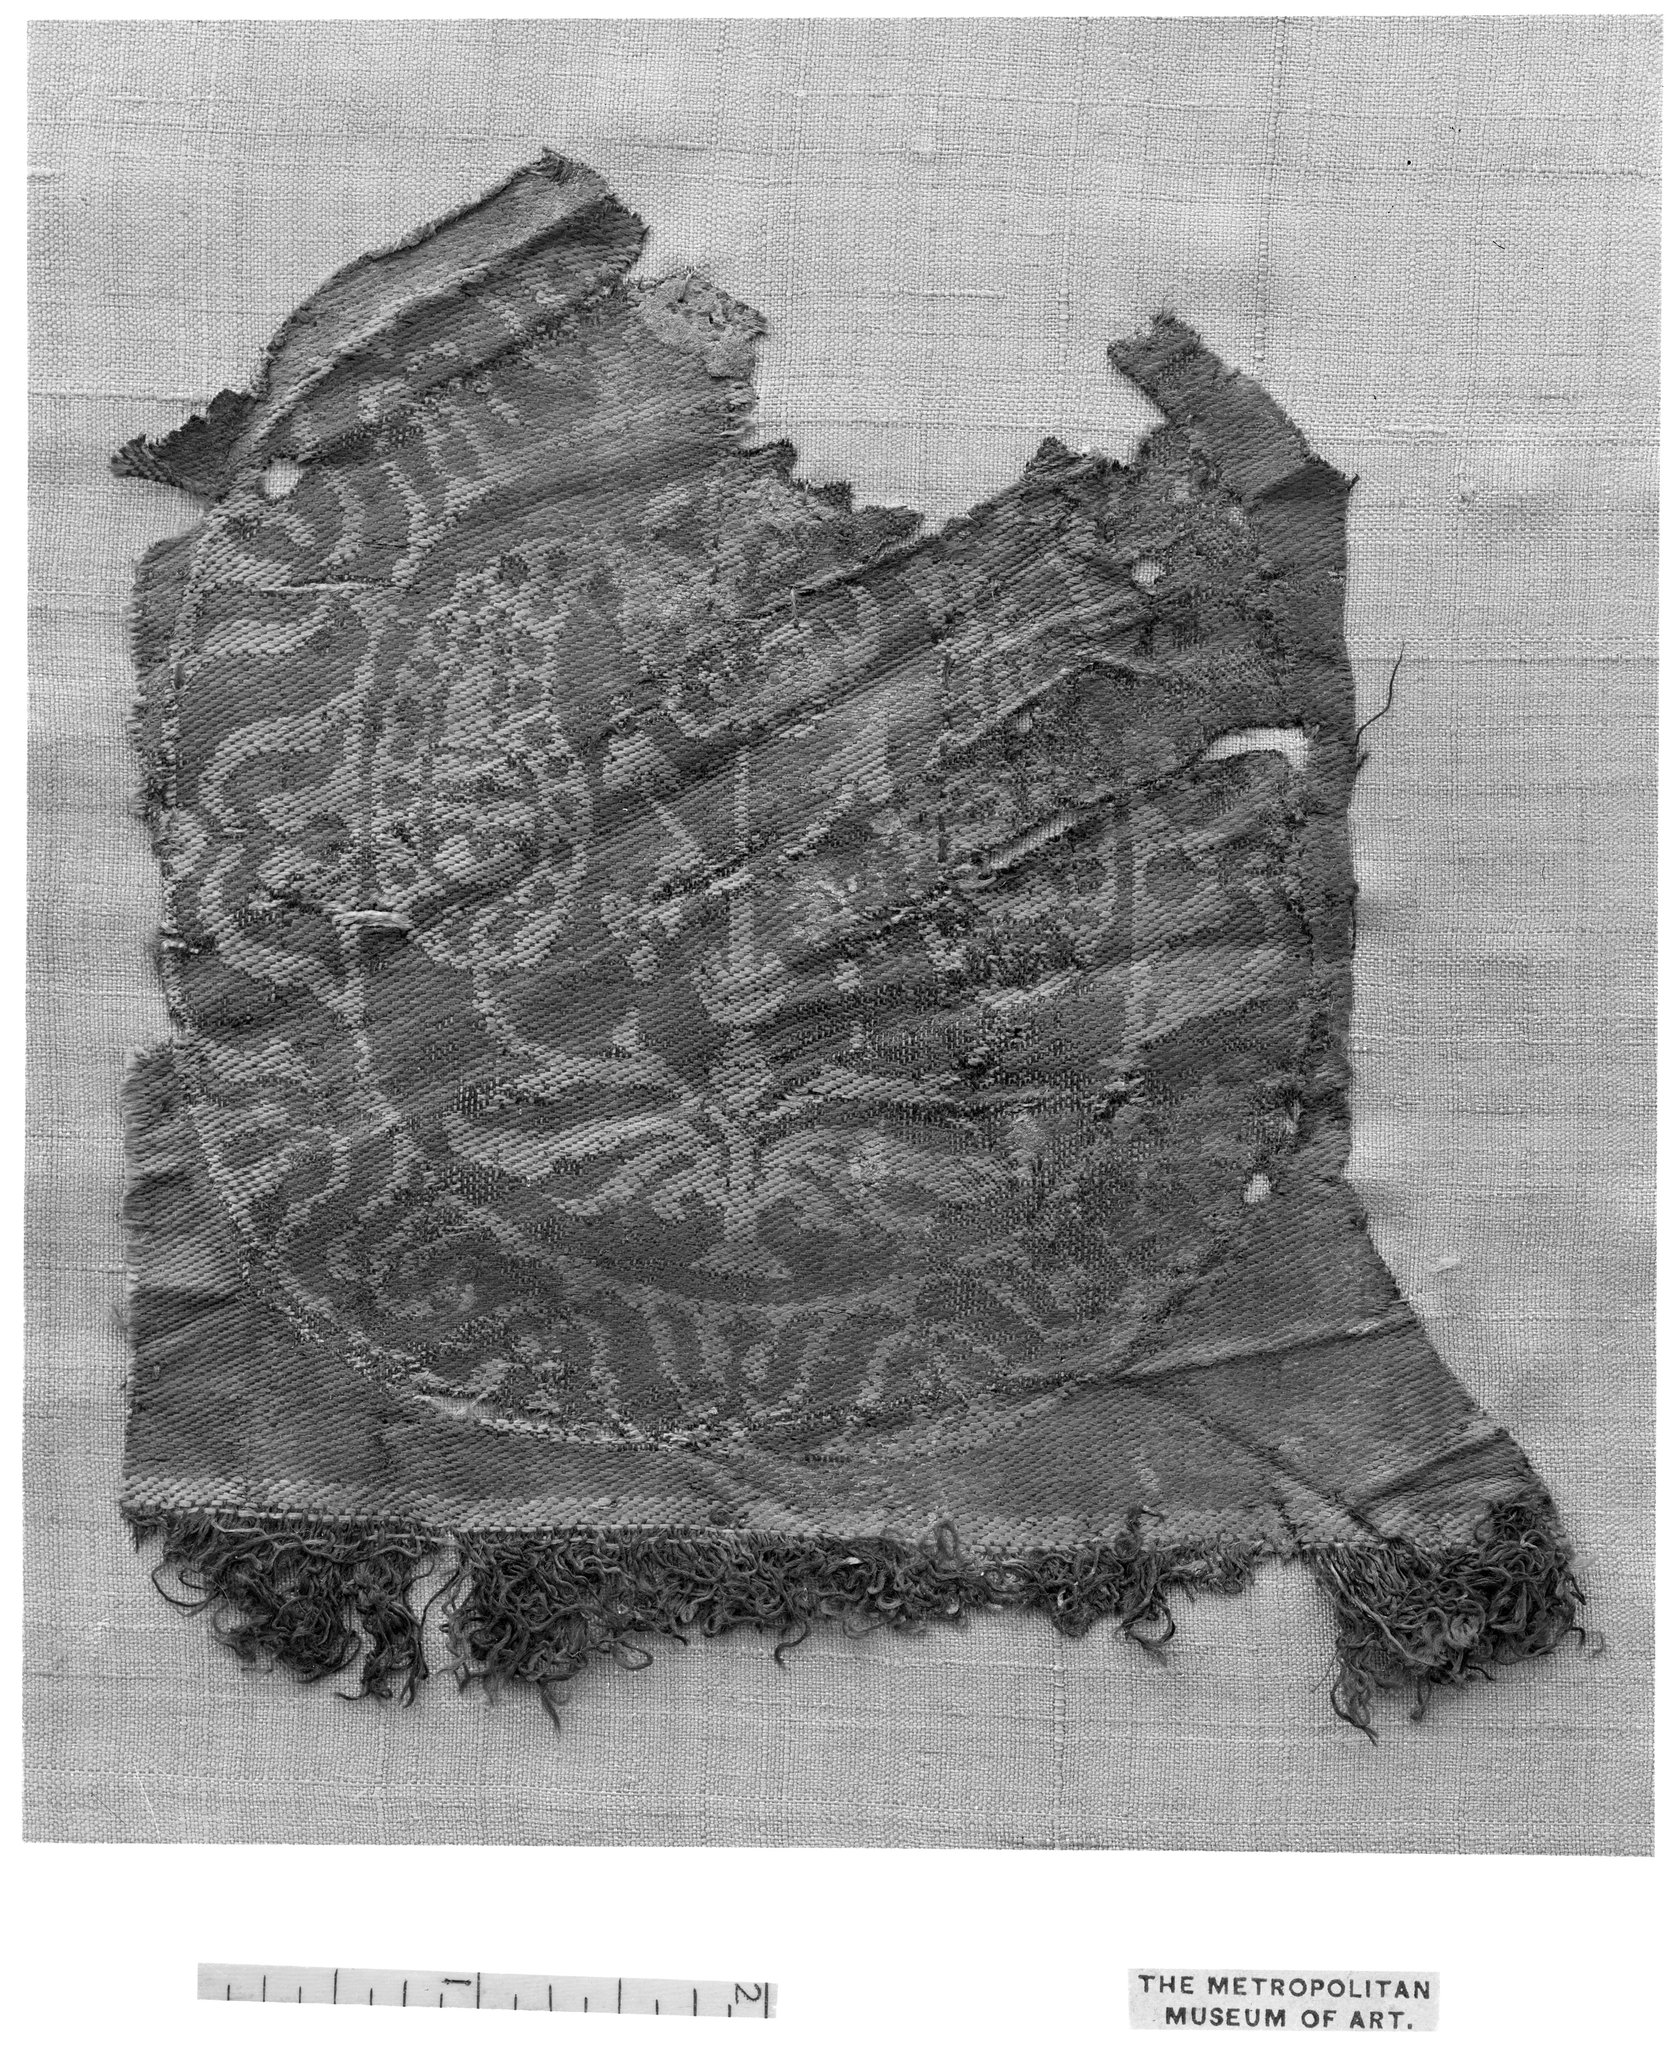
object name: textile fragment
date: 501-600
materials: silk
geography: iraq